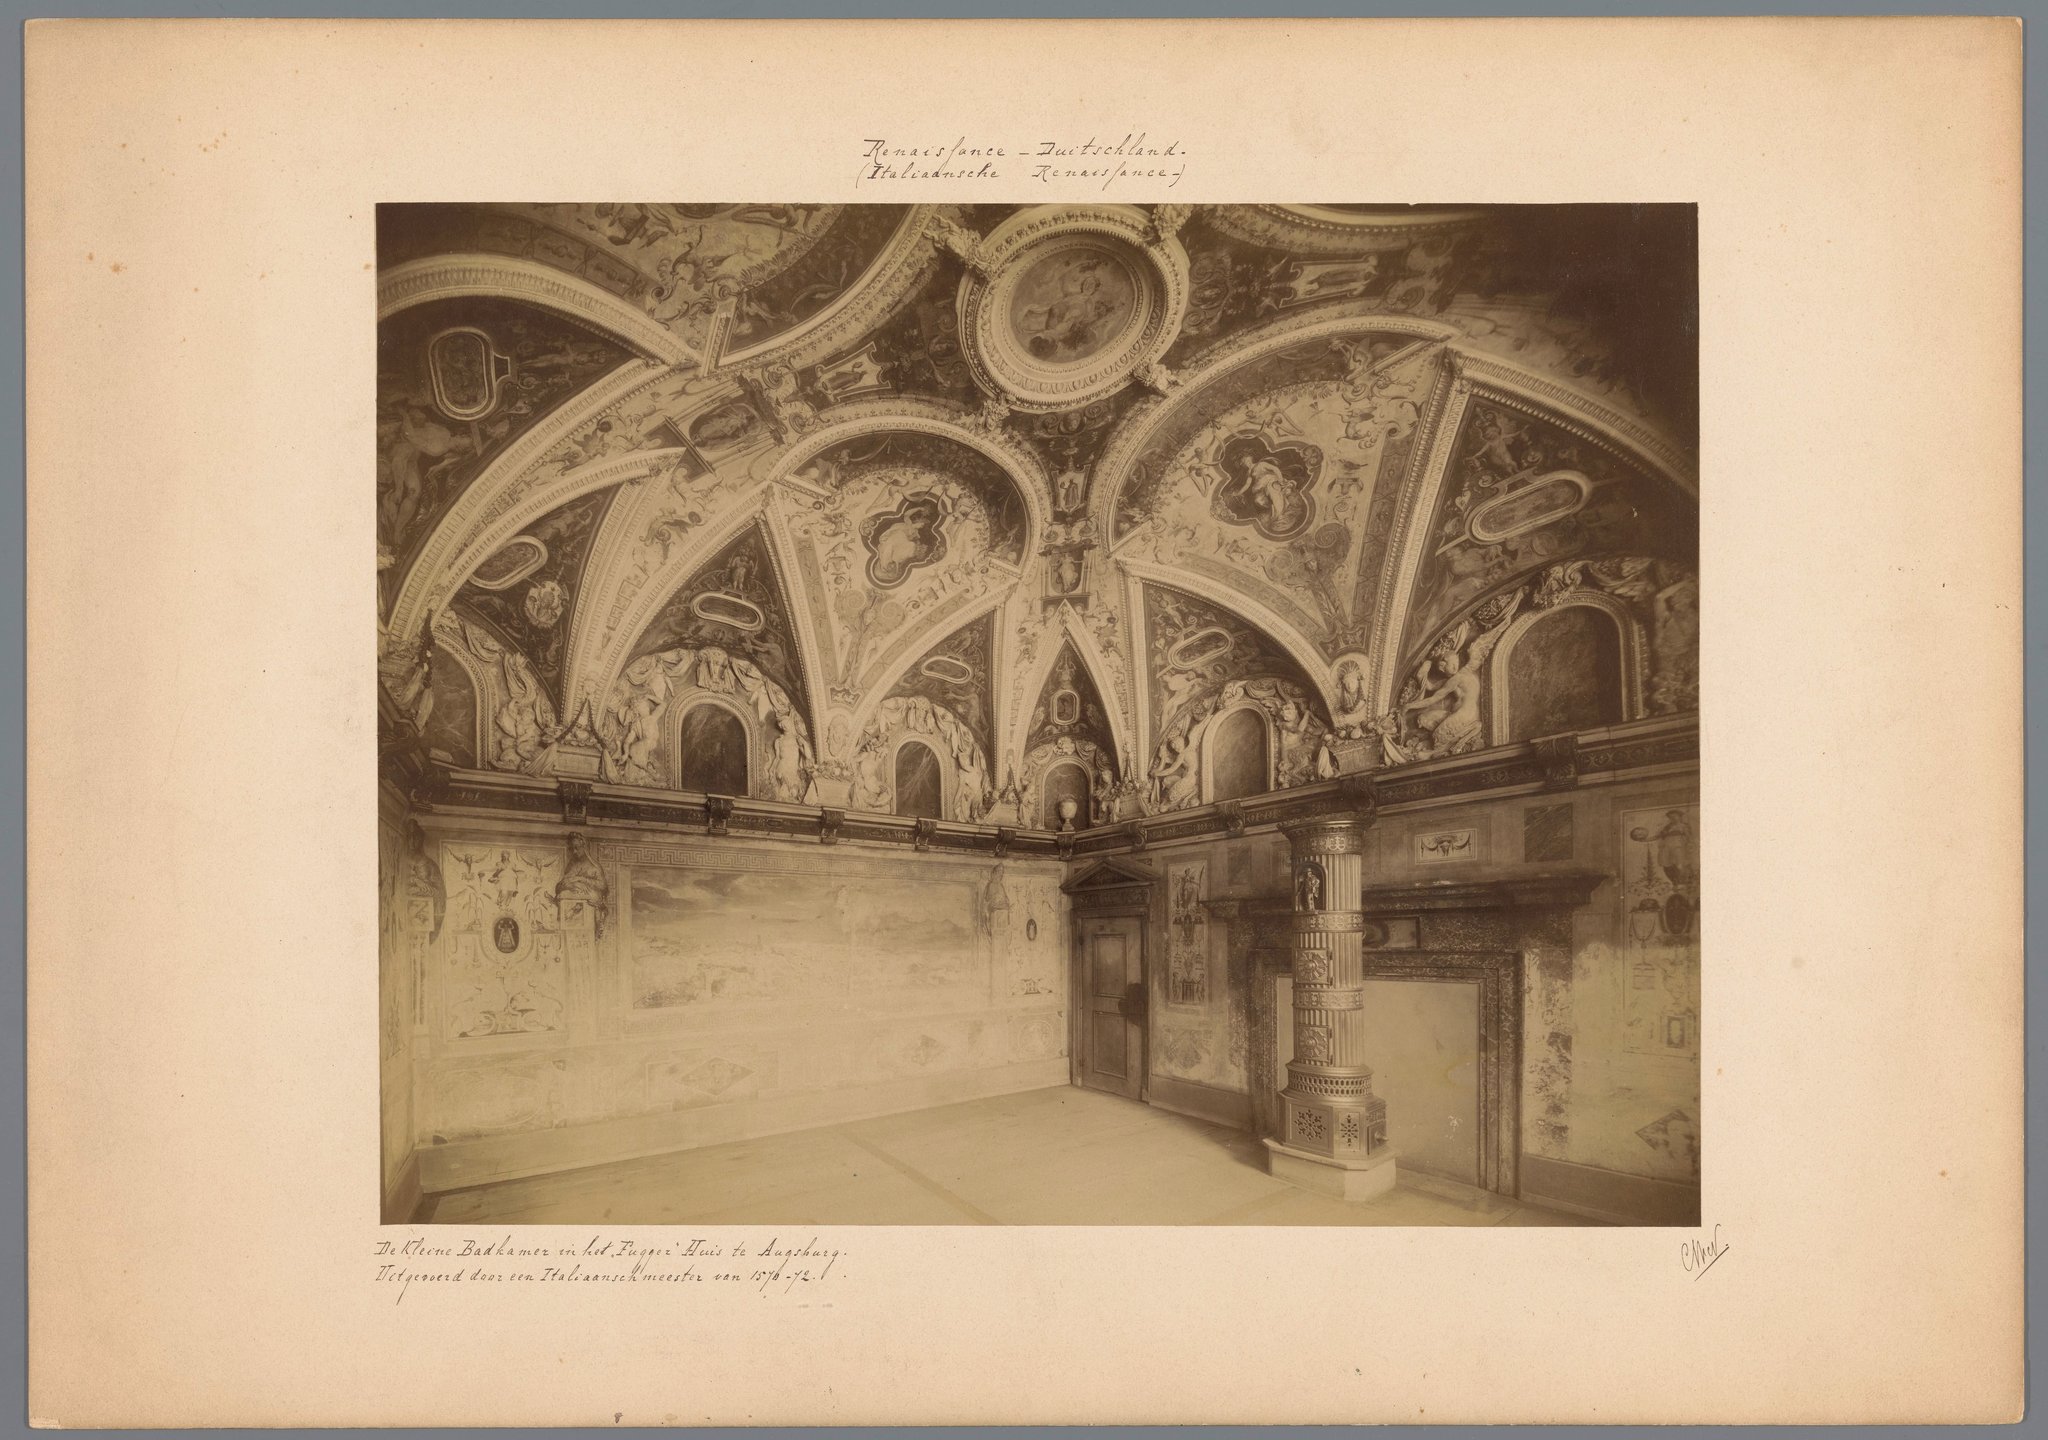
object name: photograph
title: Badkamer in de Fuggerhäuser te Augsburg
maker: Anonymous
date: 1875-1900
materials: cardboard, photographic support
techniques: albumen print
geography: augsburg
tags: interior of the house, (decorated) ceiling, augsburg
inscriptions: collector's mark: ‘INSTITUUT VOOR KUNST-NIJVERHEIDSONDERWIJS GABRIËL METSUSTRAAT No. 16 AMSTERDAM’, collector's mark: ‘KUNSTNIJVERHEIDSCHOOL QUELLINUS AMSTERDAM FRANS HALSSTRAAT 14.’, inscription: ‘CWN.’, inscription: ‘Renaissance - Duitschland. (Italiaansche Renaissance.)’